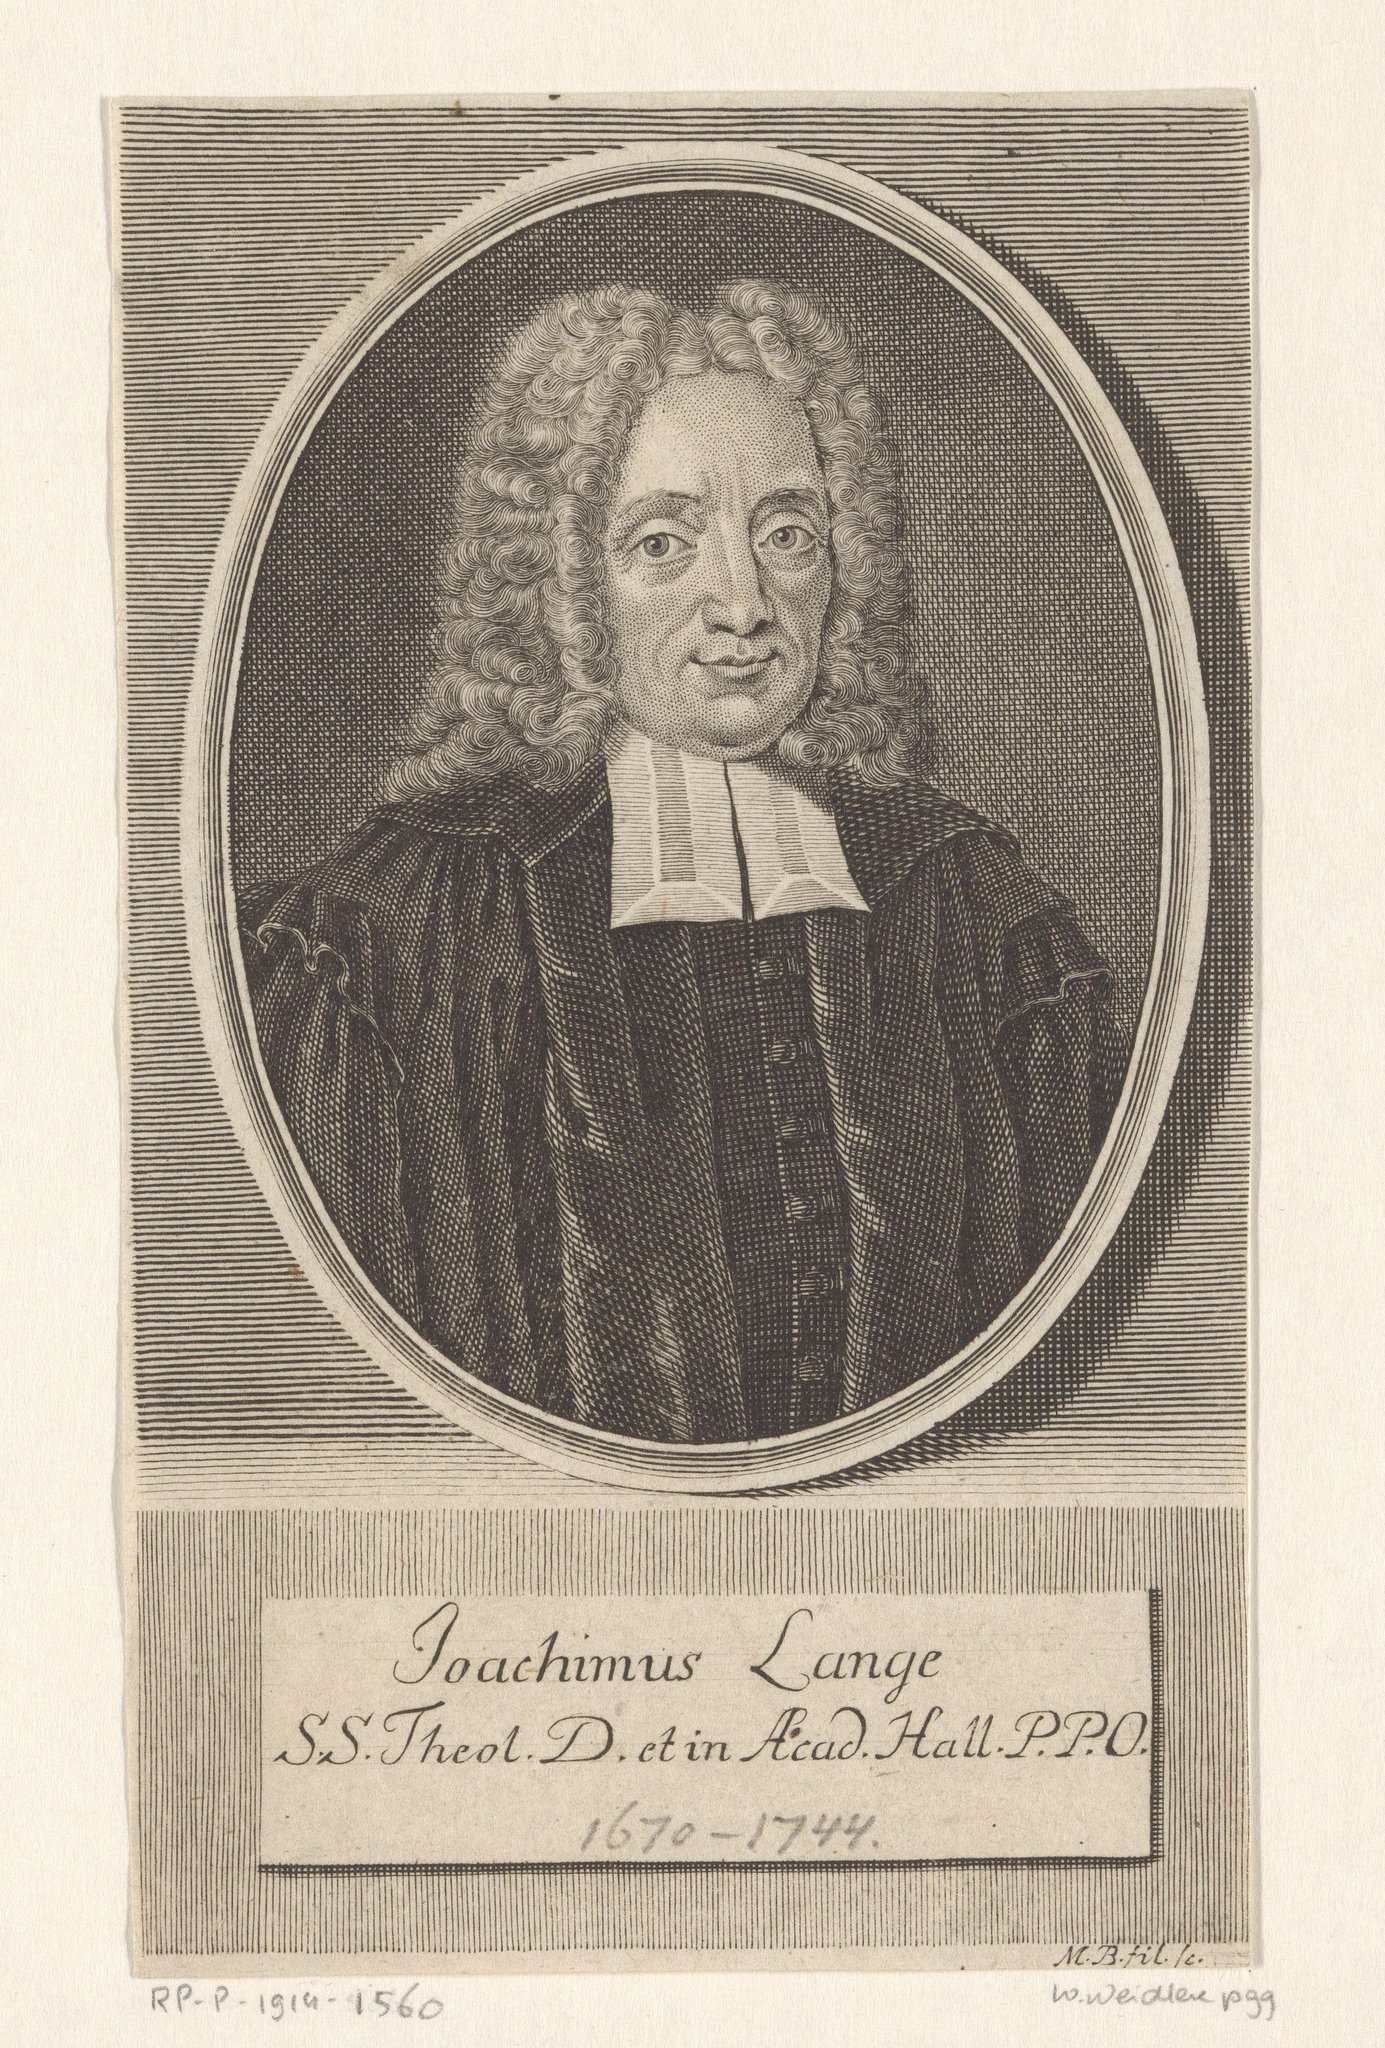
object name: print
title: Portret van Joachim Lange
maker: johann martin bernigeroth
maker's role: print maker, publisher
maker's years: 1713-1767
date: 1734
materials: paper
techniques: engraving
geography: leipzig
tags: joachim lange, historical persons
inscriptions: collector's mark: Lugt 2228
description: Prent ook gebruikt in: Deutsche Acta Eruditorum (...). dl. 180. Leipzig: Johann Gottlieb Gleditsch, 1734.